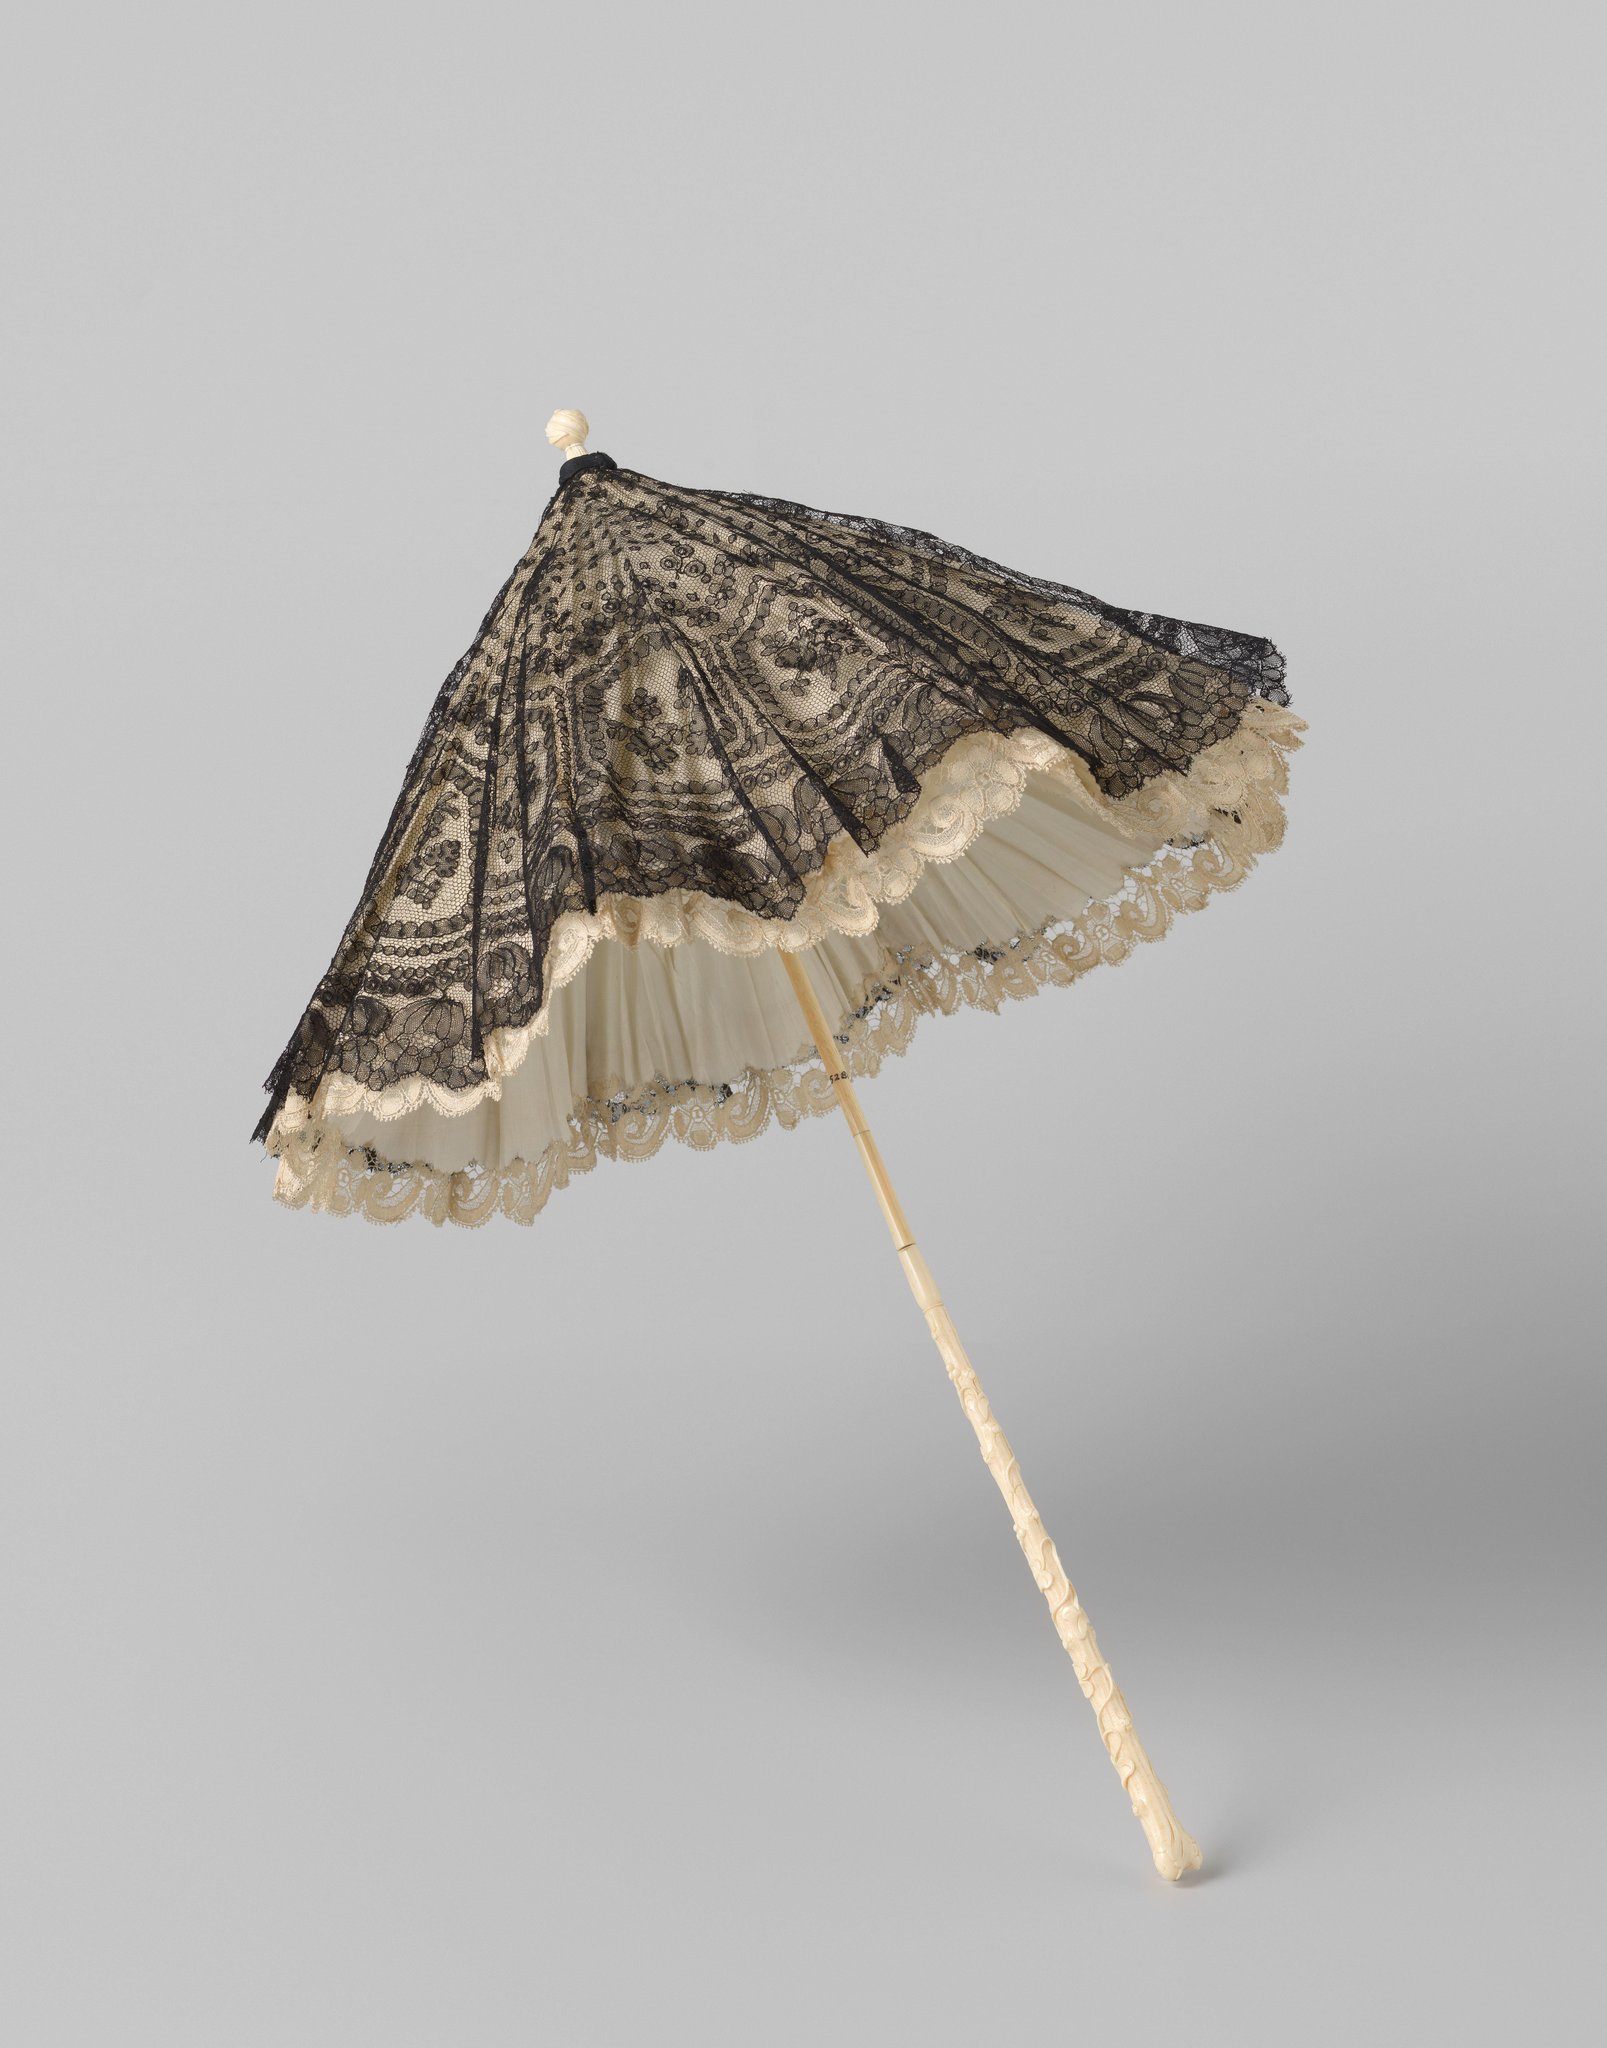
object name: parasol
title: Parasol met een dek van zwarte Chantilly-kant op witte tafzijde, gevoerd met witte ponjézijde, gesneden ivoren stok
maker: Anonymous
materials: ivory, metal, silk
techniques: cutting, weave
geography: france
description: Parasol van zwarte Chantilly-kant met moesjes in het midden, schakelrand van medaillons en geschulpte buitenrand met hangende tulpen, dicht op elkaar geplaatst, op witte tafzijde. De voering is van witte ponjé-zijde versierd met een strook machinale blonde kant. De stok is van ivoor, gesneden als een knoestige stam, waaromheen zich ijle klimopranken slingeren in reliëf. Geen haak. Halverwege kan de stok losgeschroefd worden. Bovenop een ronde knop van ivoor.